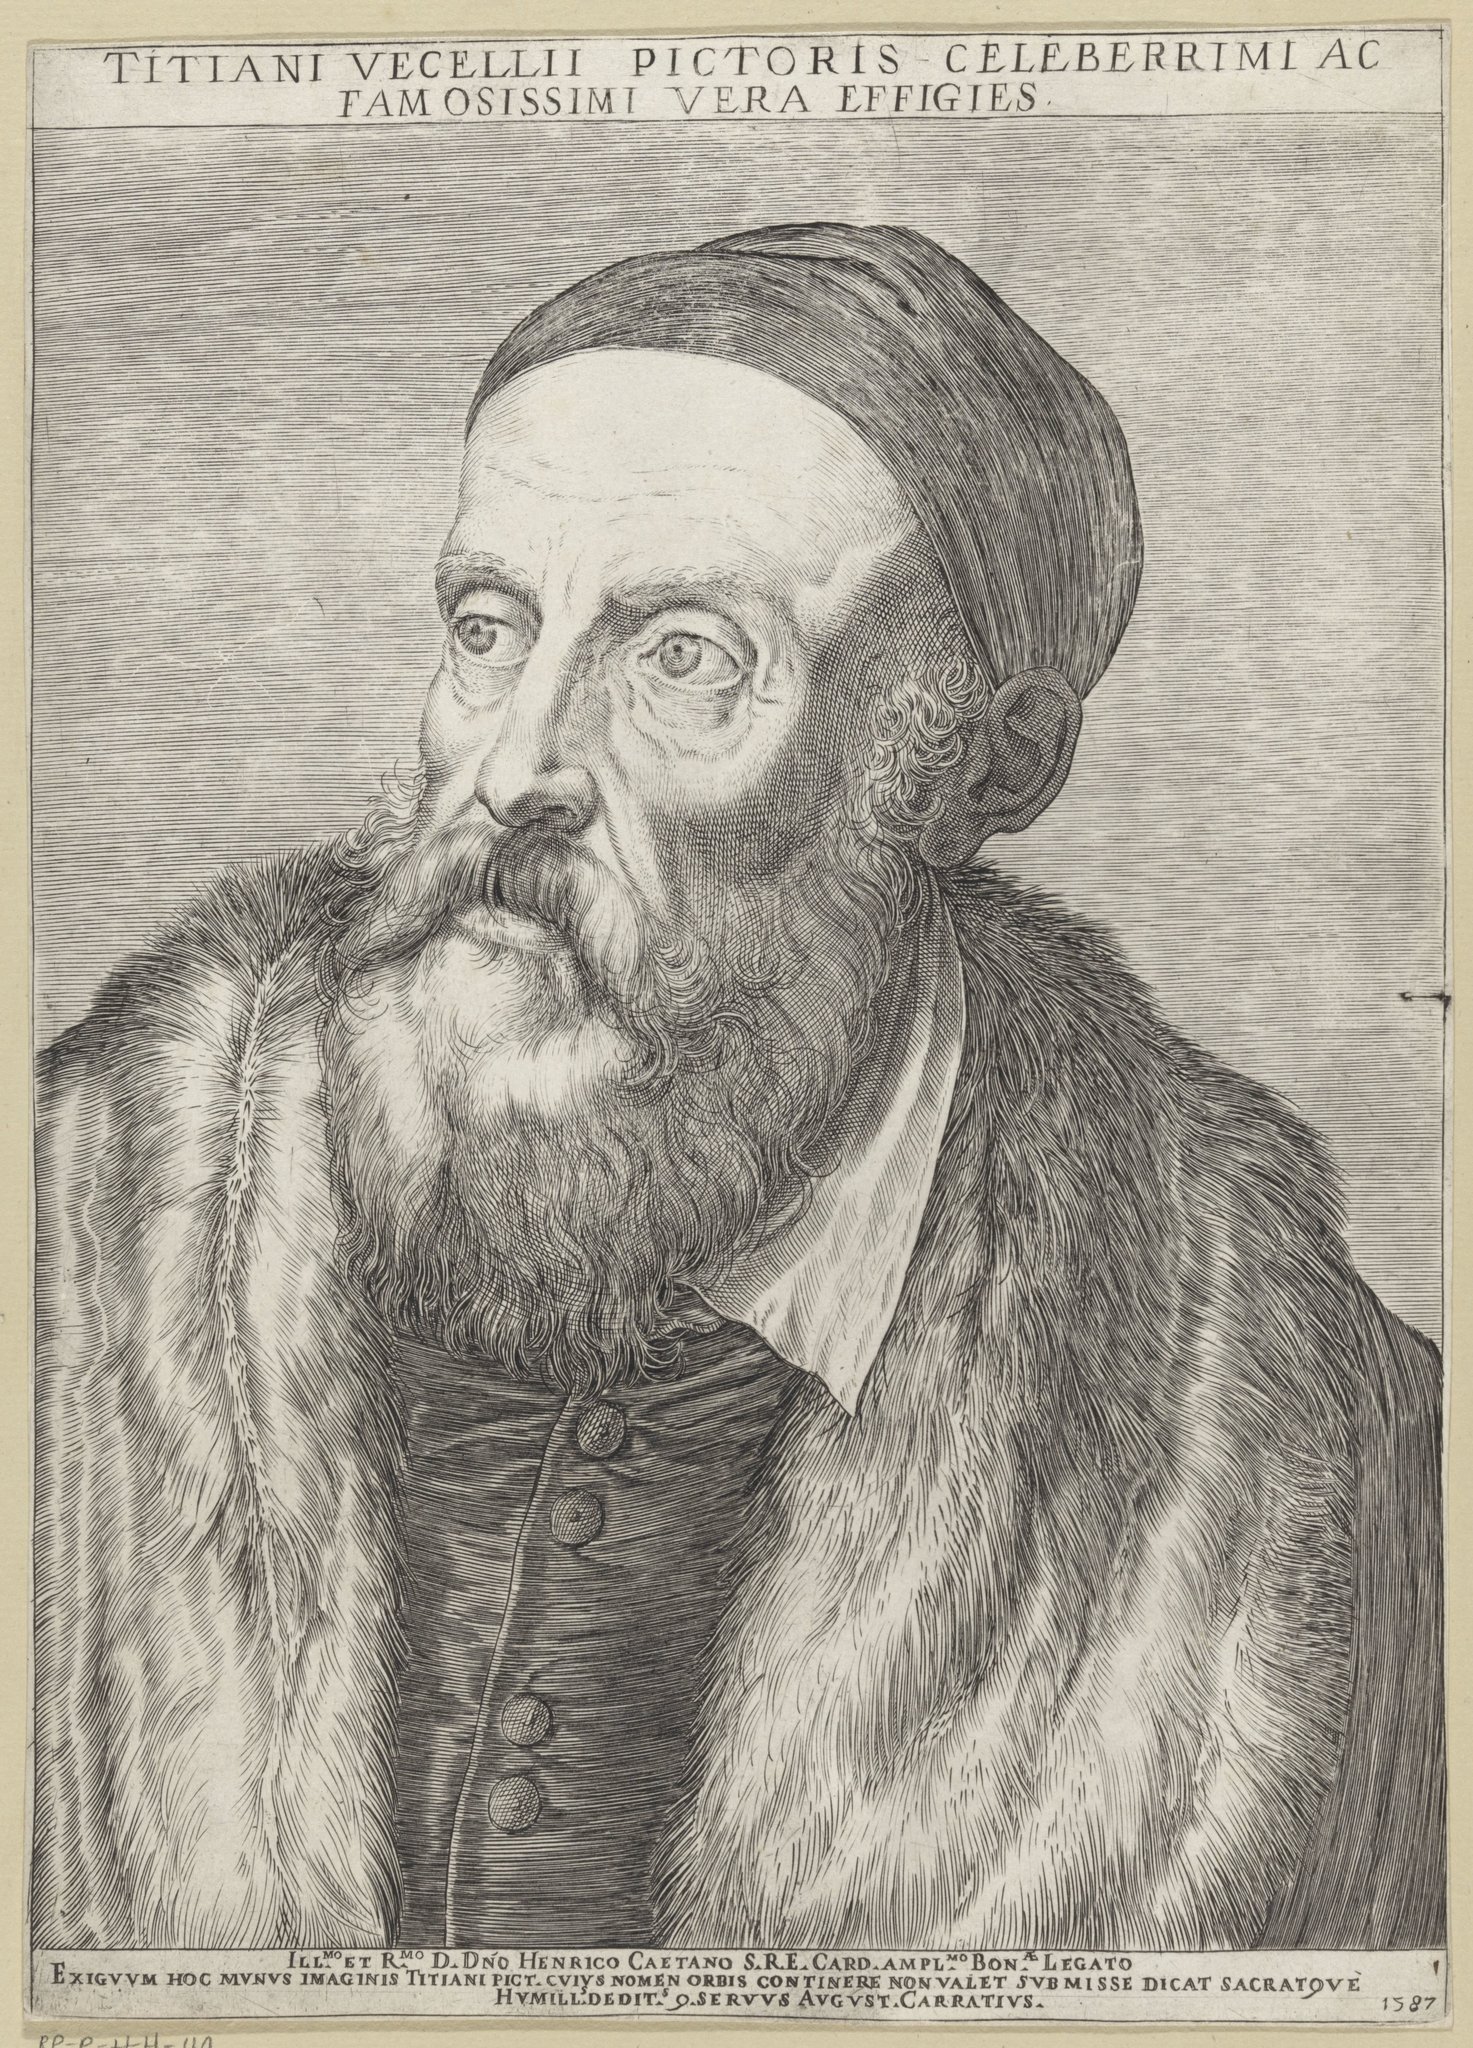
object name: print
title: Portret van schilder Titiaan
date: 1587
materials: paper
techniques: engraving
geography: italy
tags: venice, titiaan, historical persons, portrait, self-portrait of artist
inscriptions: collector's mark: Lugt 11, collector's mark: Lugt 10, number: ‘1’, inscription: ‘N 128 [...] 16 [...]’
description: Naar geschilderd zelfportret van Titiaan in de Staatliche Museen Preussischer Kulturbesitz, Gemäldegalerie te Berlijn.